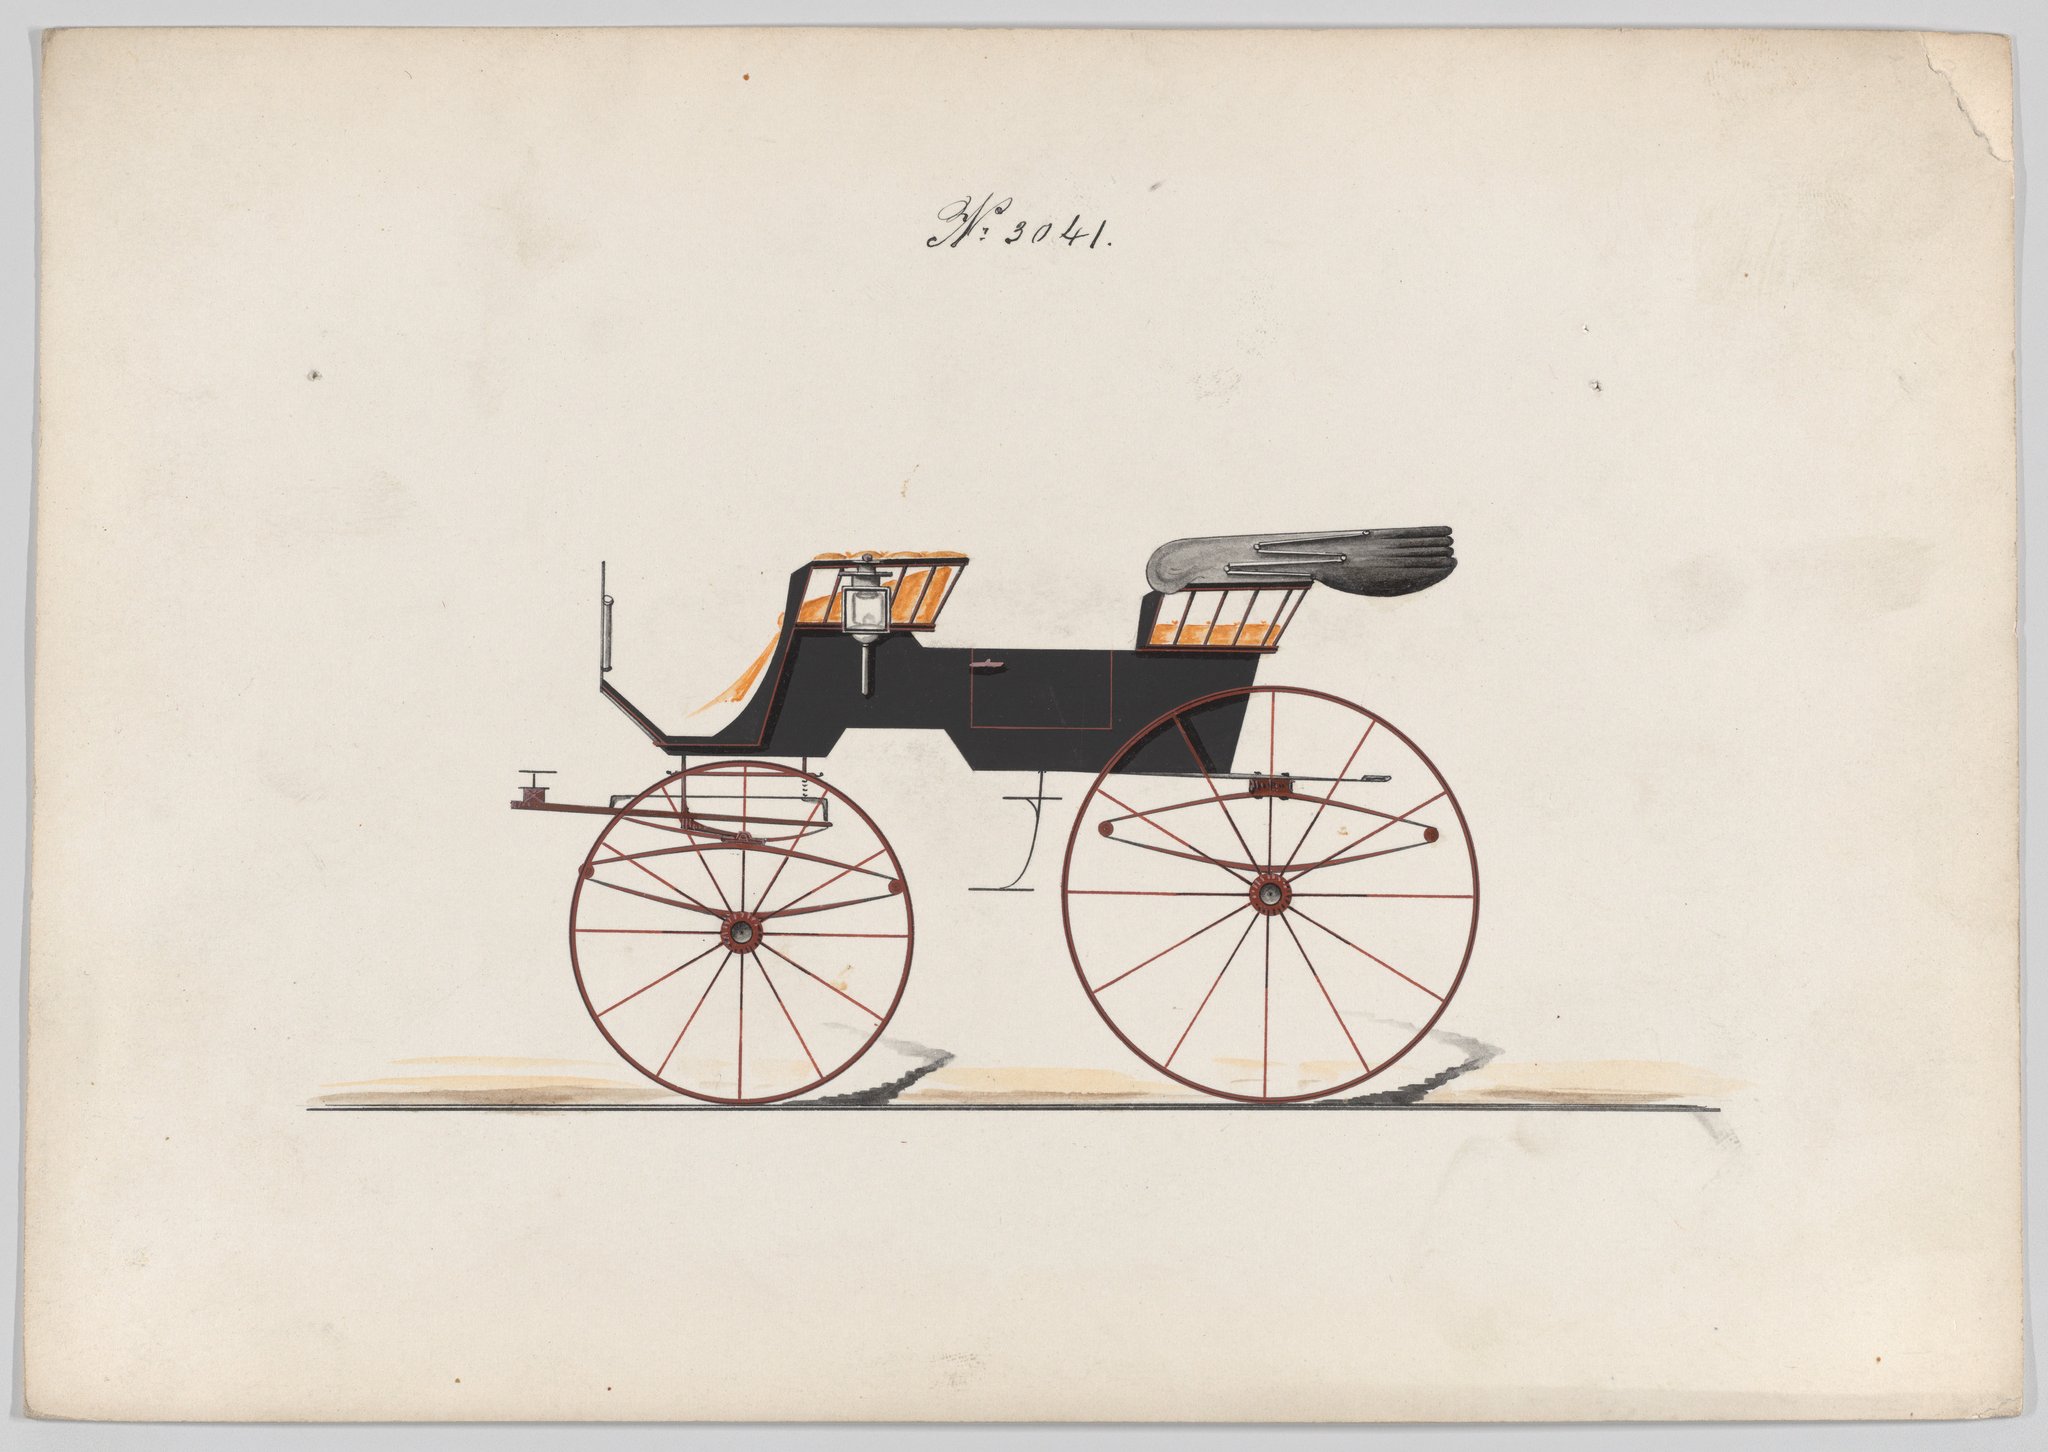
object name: drawing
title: Design for 2 seat Phaeton, no. 3041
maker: brewster & co.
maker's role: manufacturer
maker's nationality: american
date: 1874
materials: gouache, ink, watercolor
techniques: pen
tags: carriages